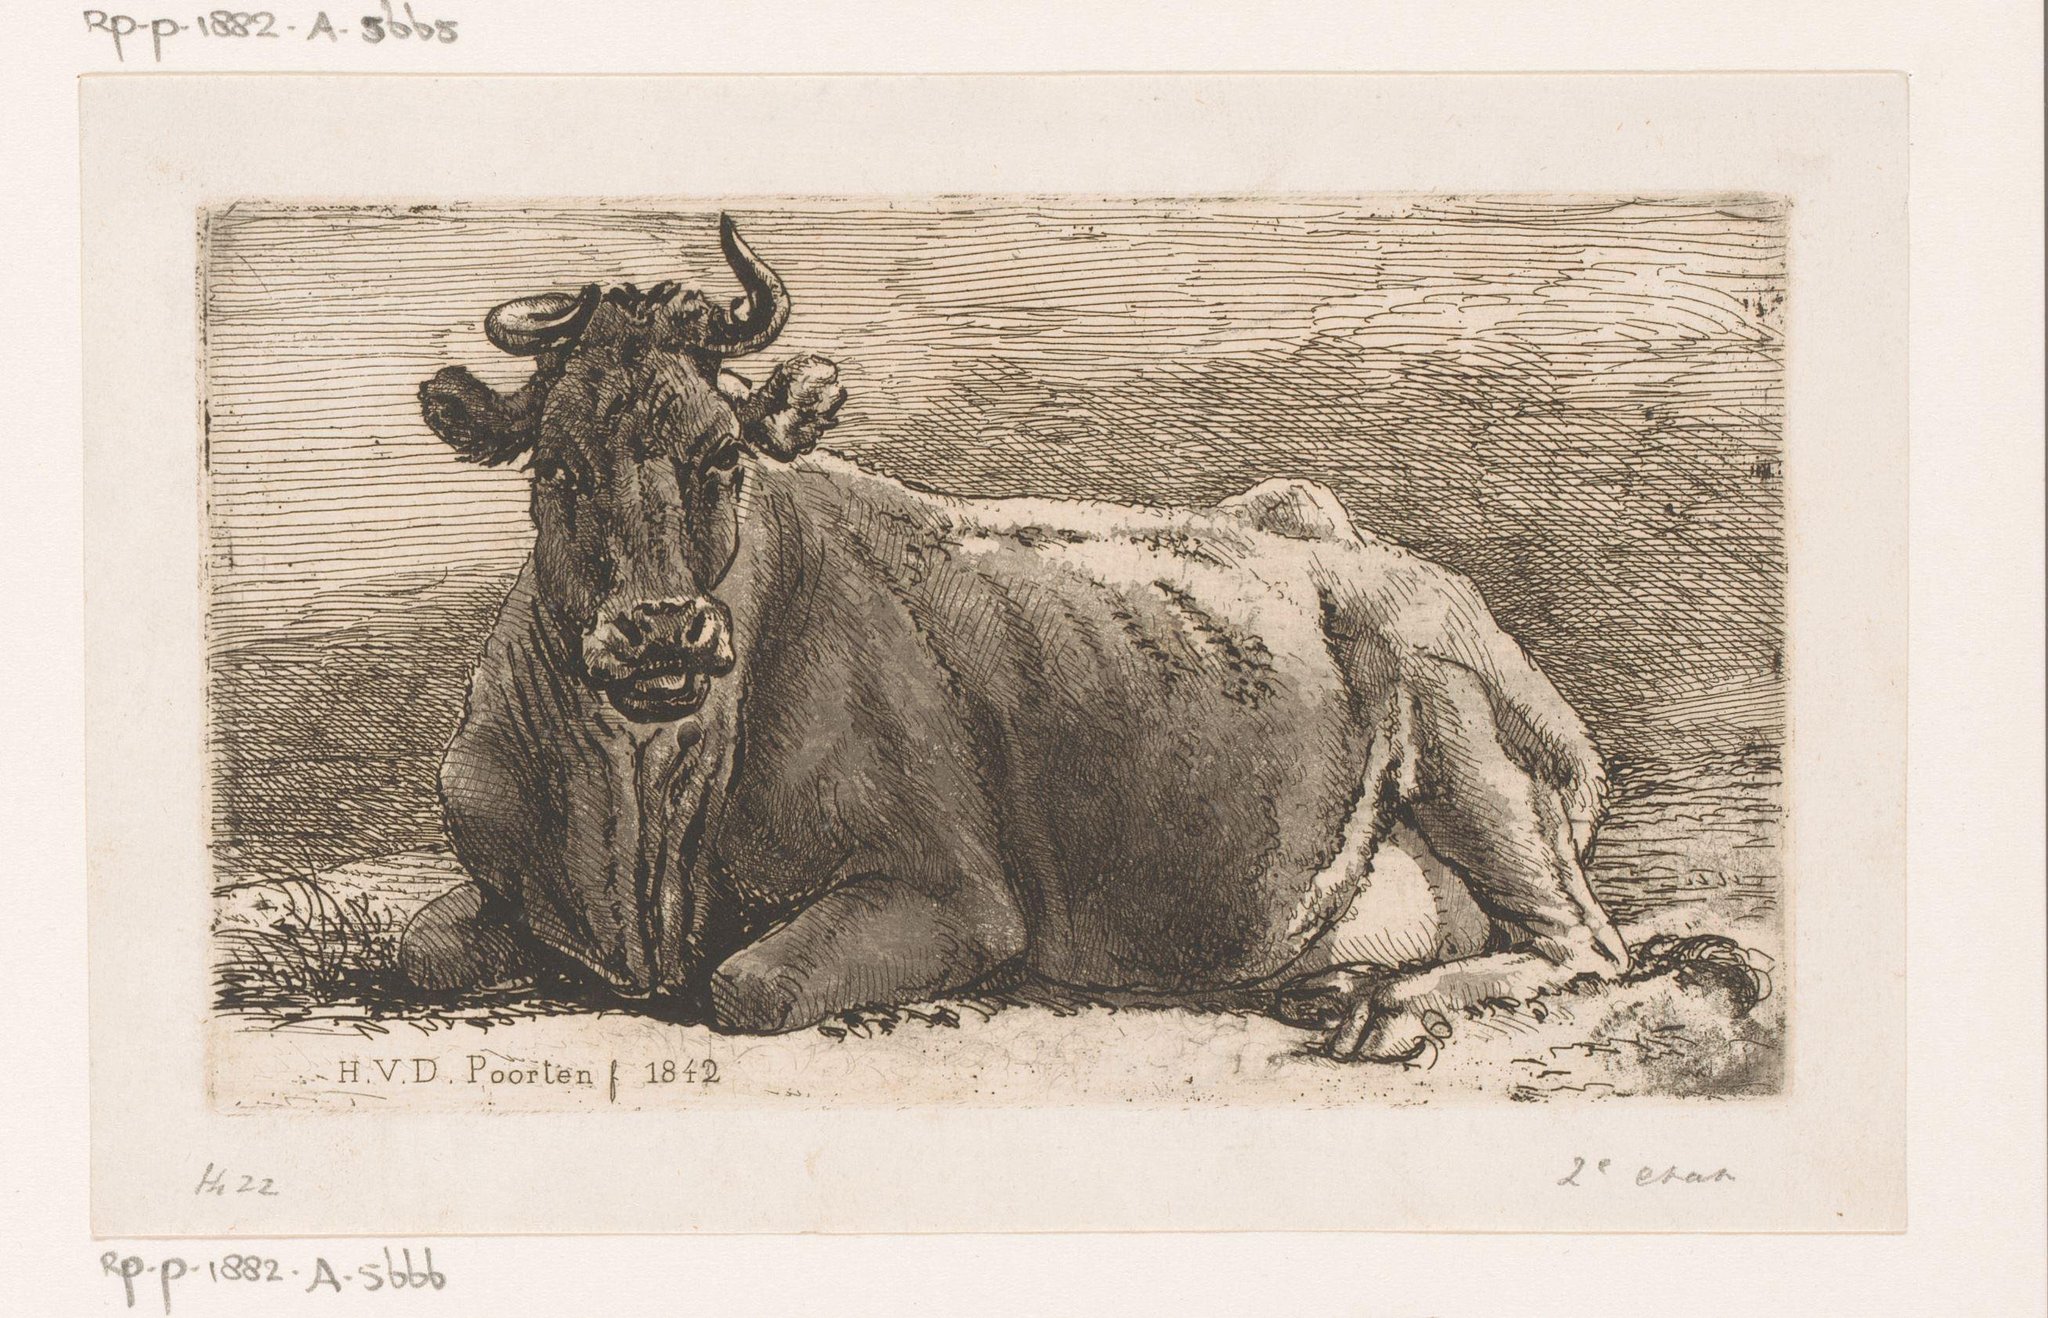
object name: print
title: Liggende koe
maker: hendrik jozef franciscus van der poorten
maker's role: draughtsman, print maker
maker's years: 1789-1874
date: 1842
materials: paper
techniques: aquatint, etching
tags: cow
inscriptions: collector's mark: Lugt 2228